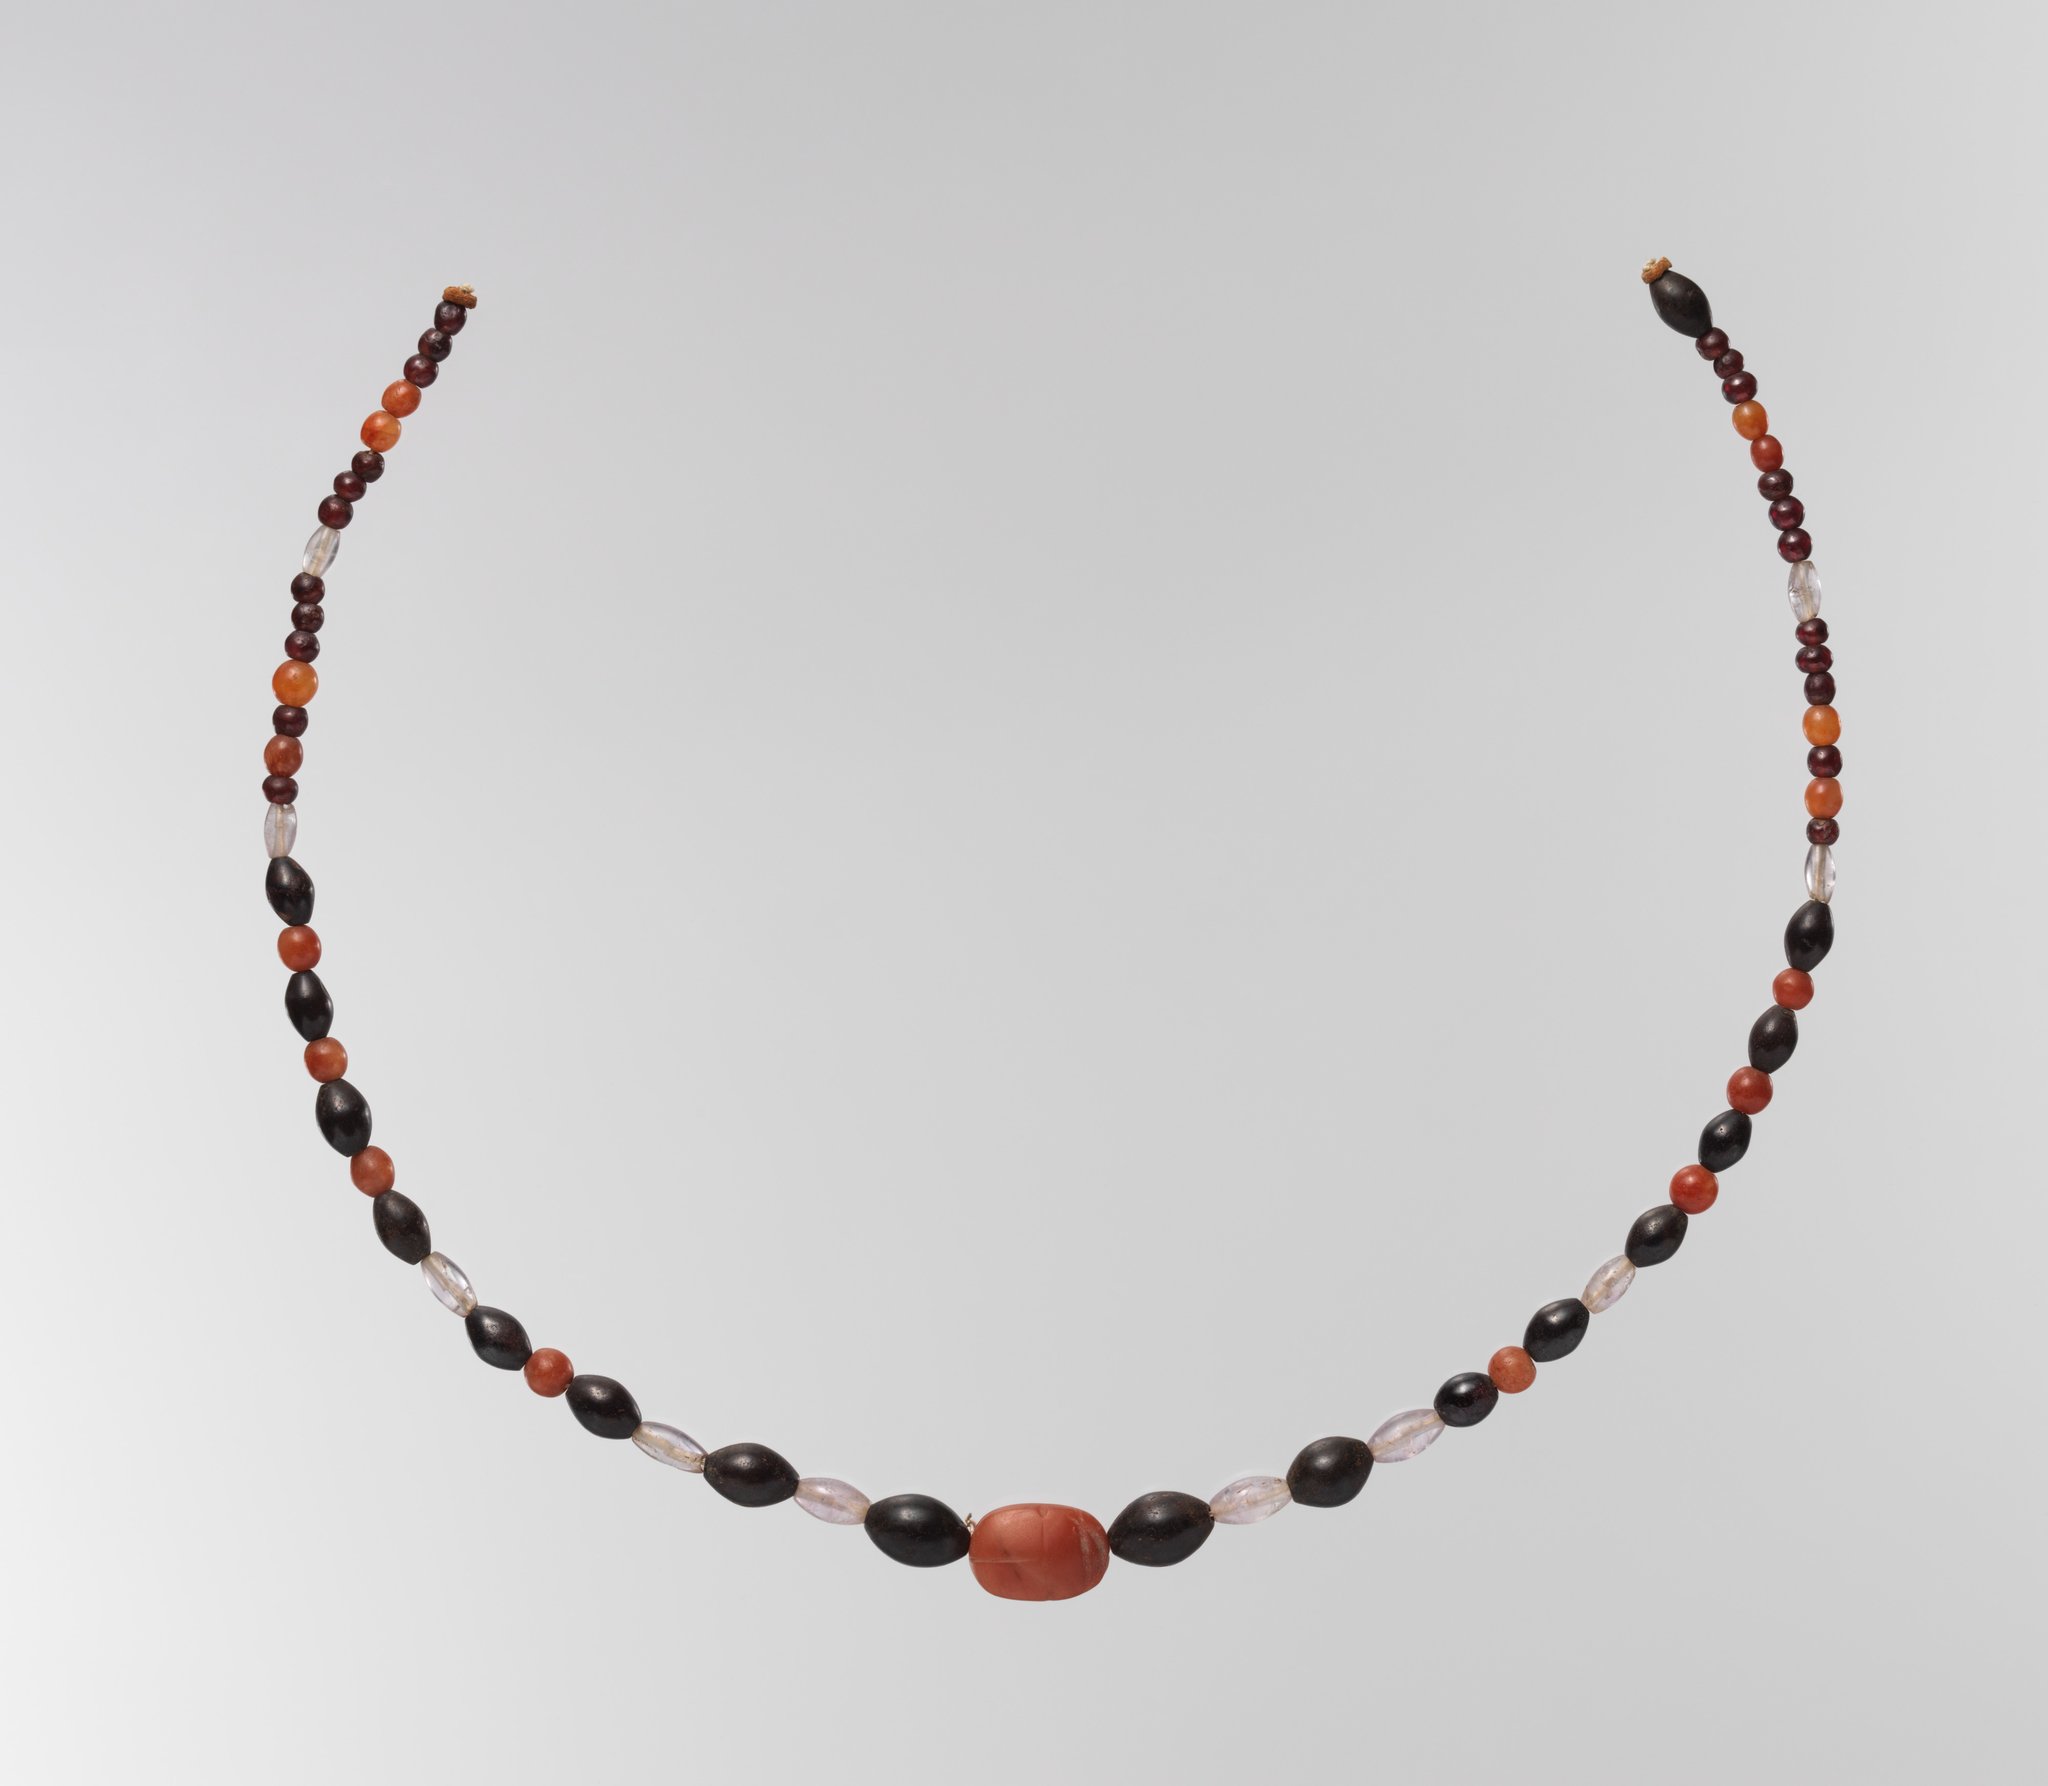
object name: string of bead with scarab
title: String of beads with scarab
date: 2030-1640 BCE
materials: gemstone, mineral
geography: egypt